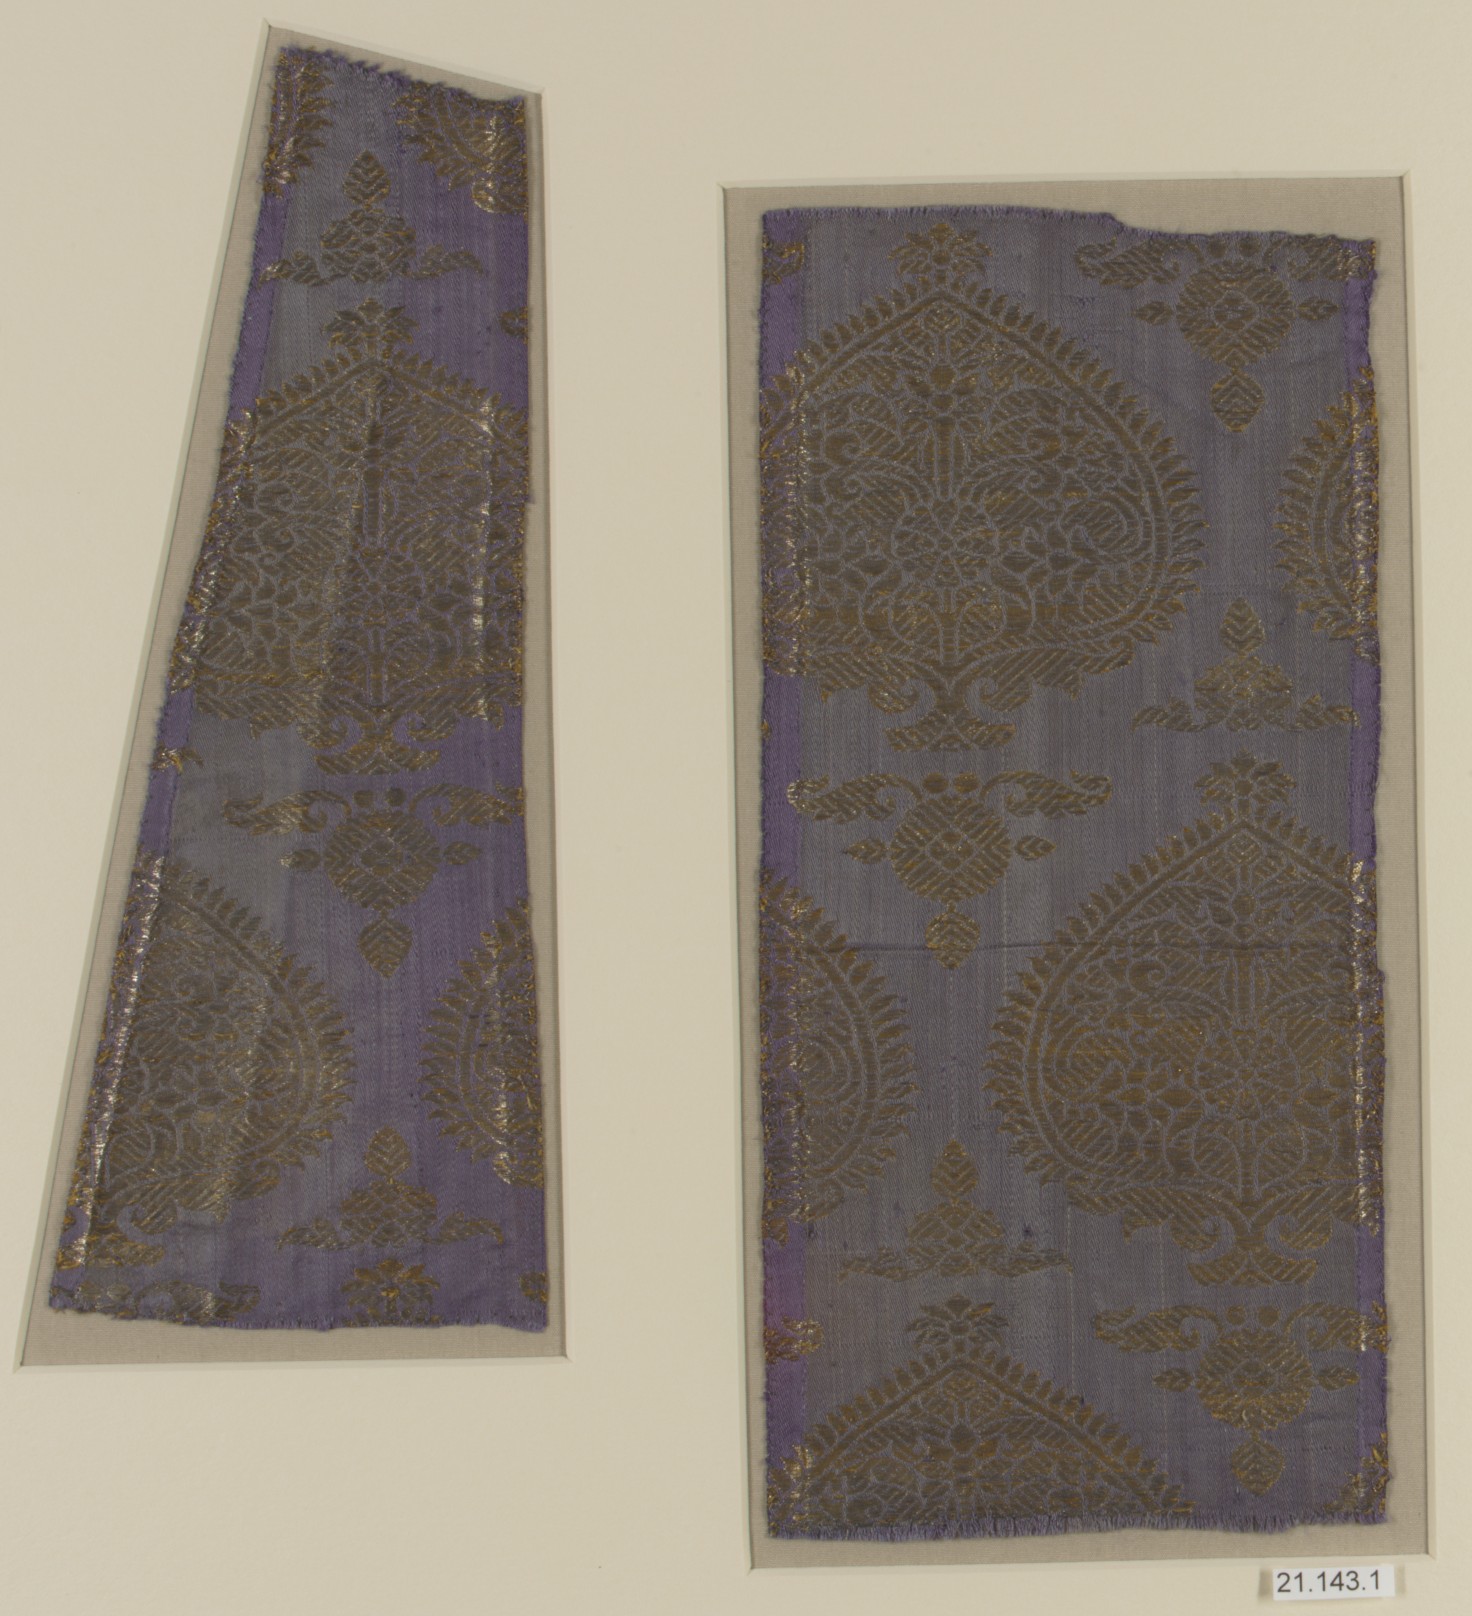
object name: brocade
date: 1701-1900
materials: silk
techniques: brocade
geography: india